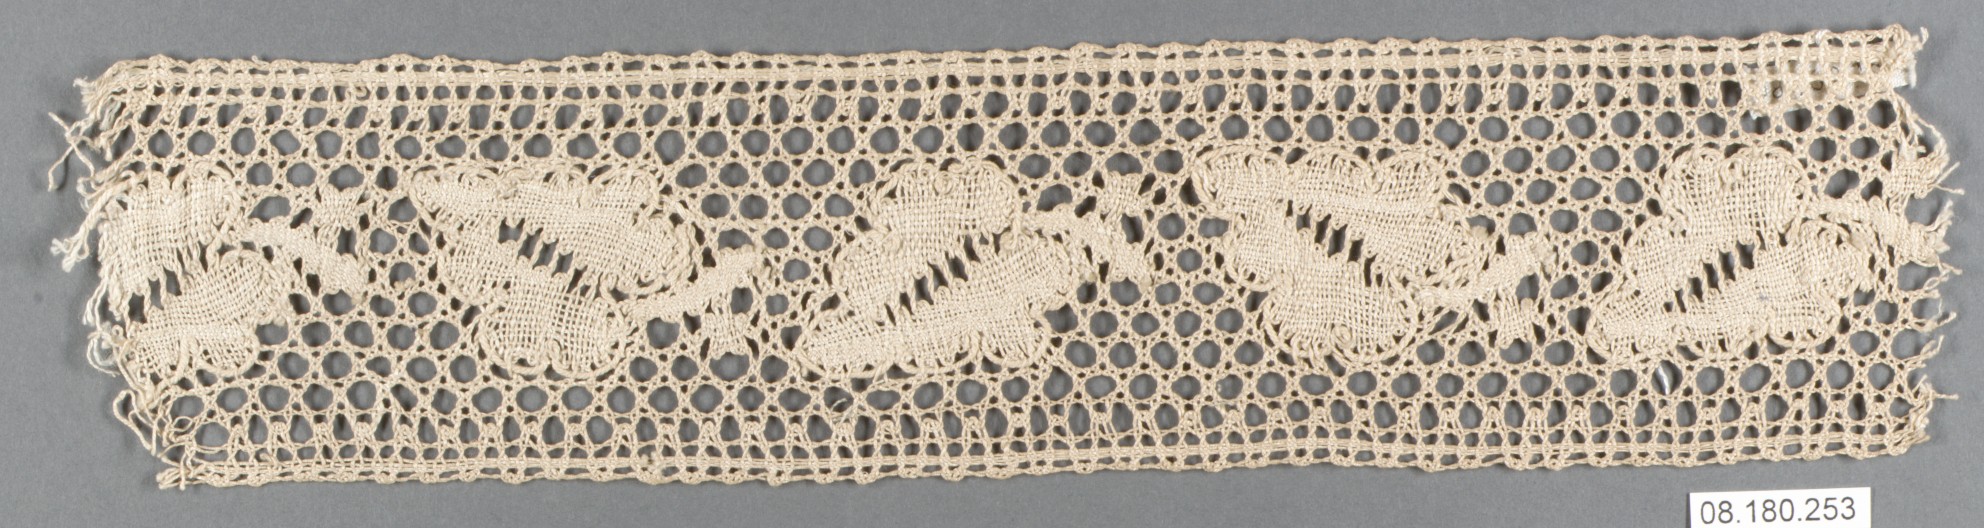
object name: insertion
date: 1801-1900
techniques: lace